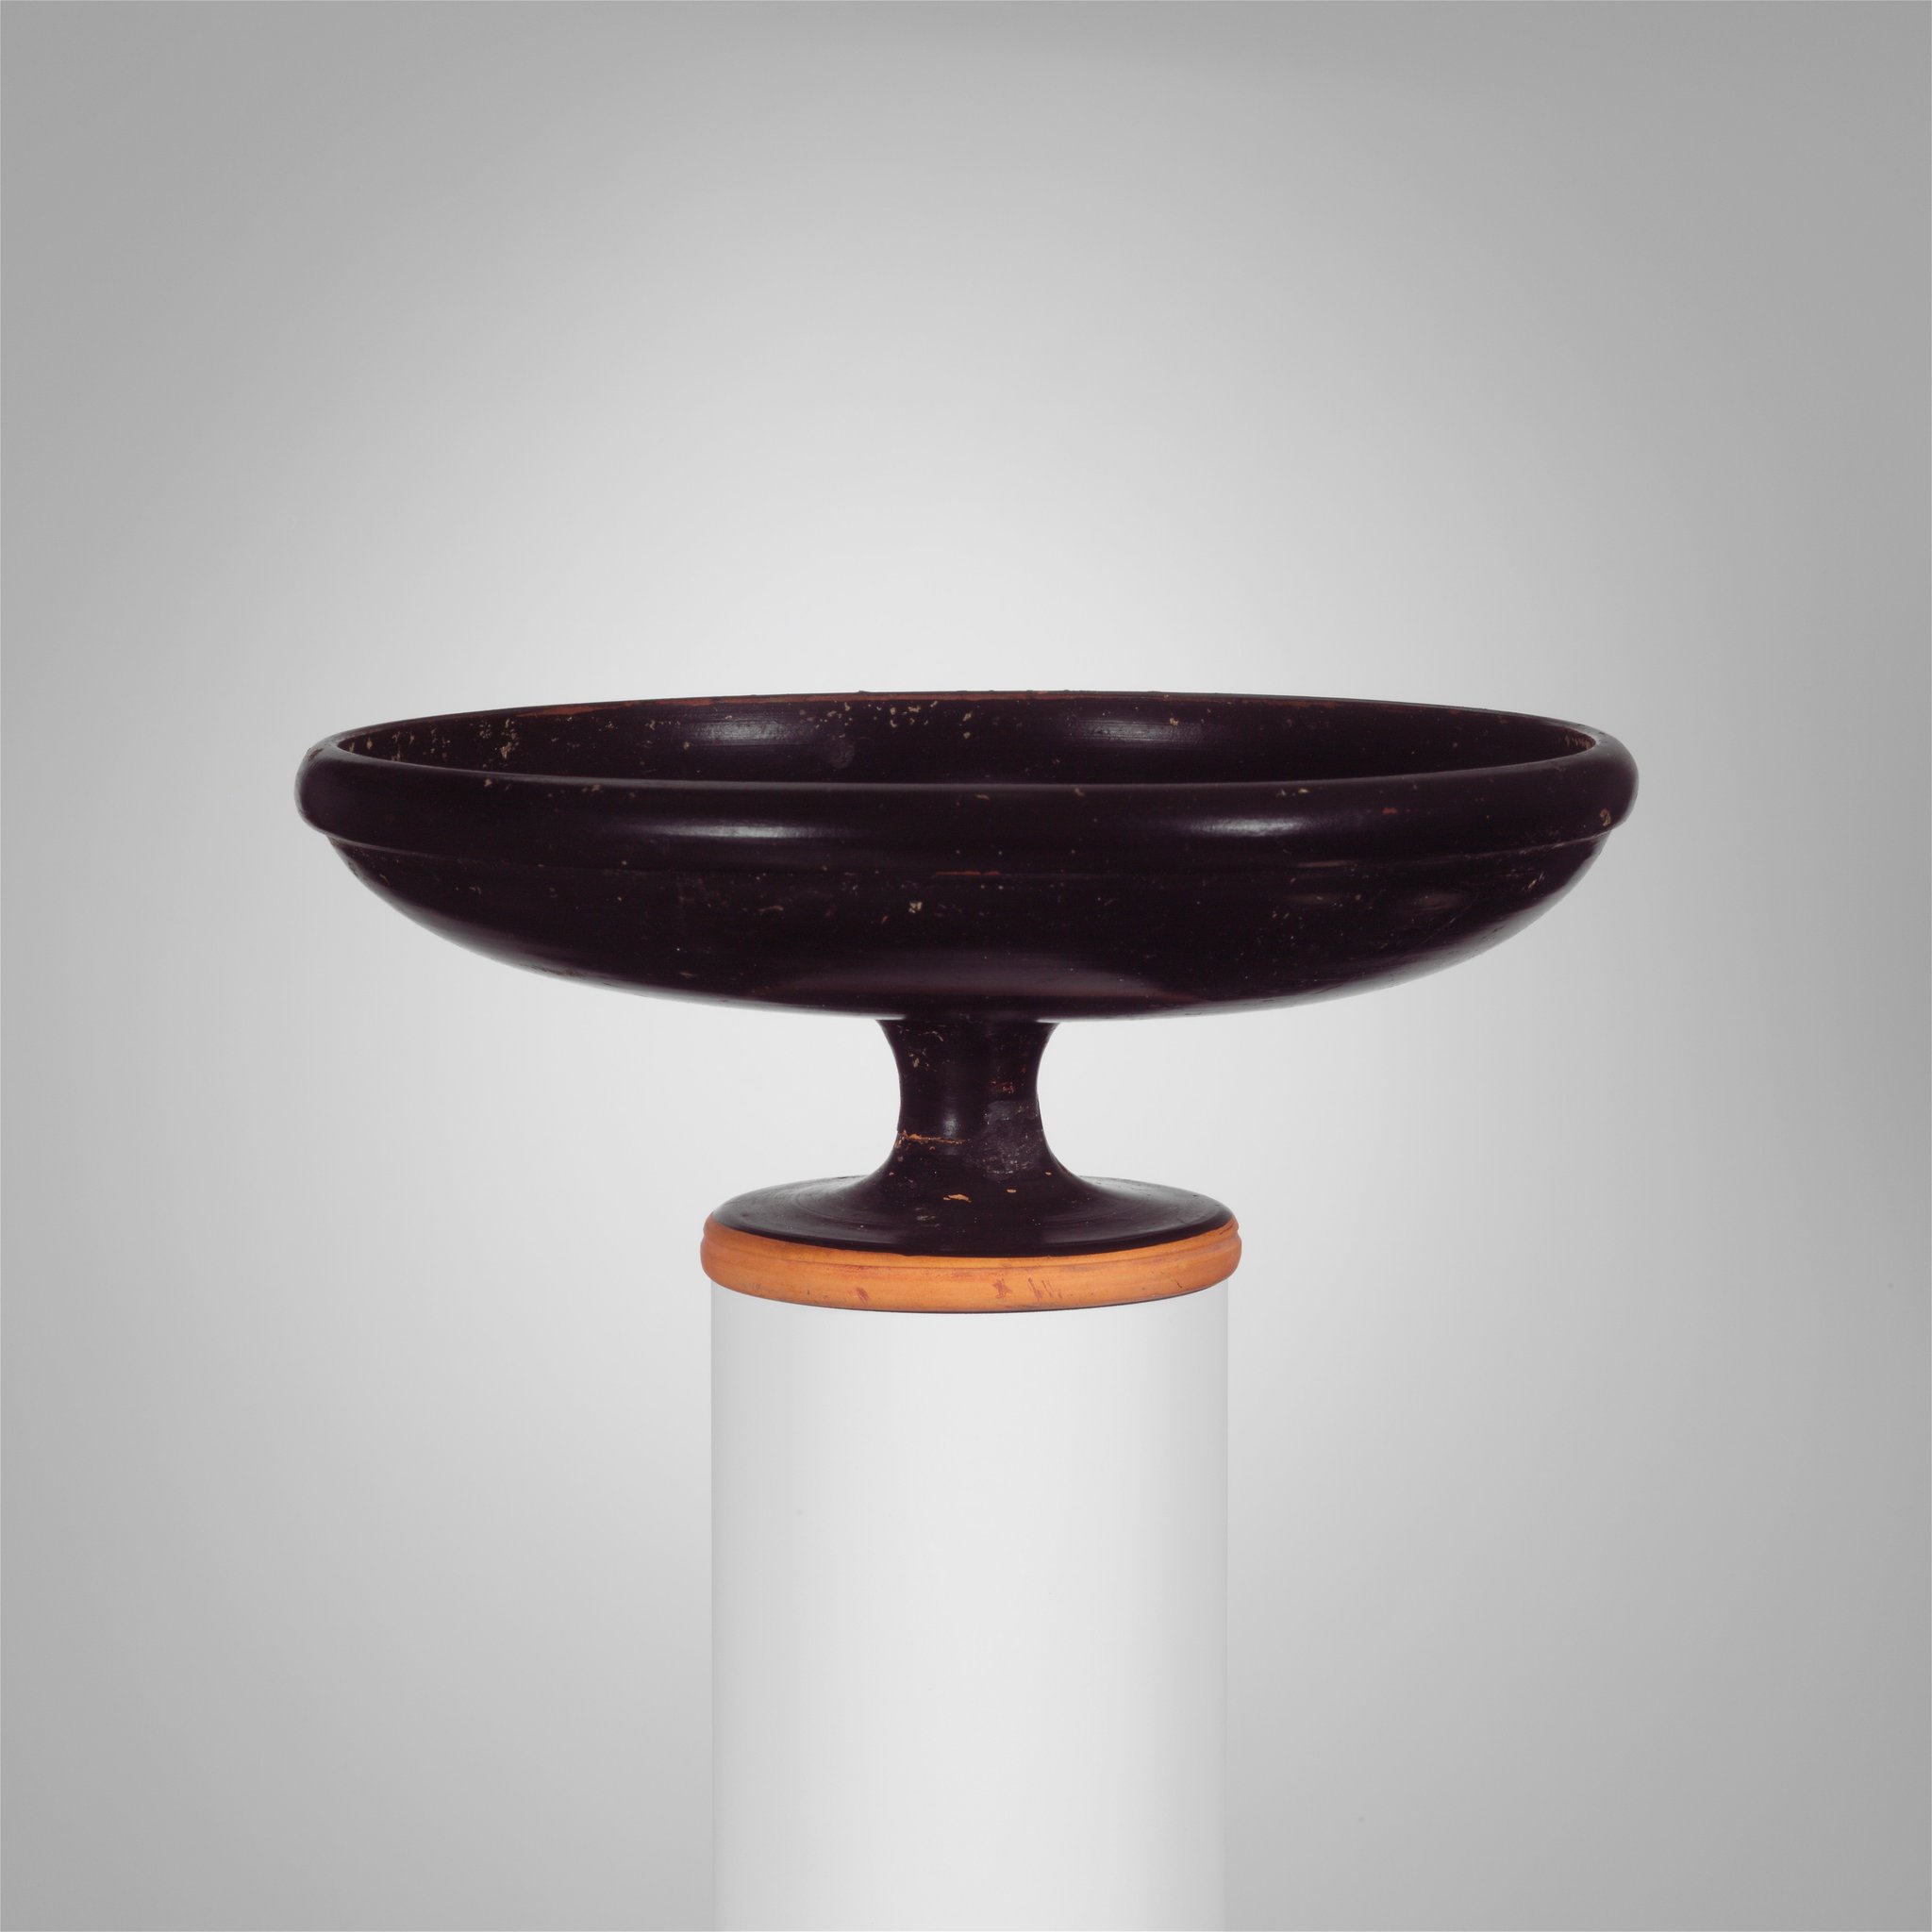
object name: stemmed dish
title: Terracotta stemmed dish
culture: greek, attic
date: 500-401 BCE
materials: terracotta